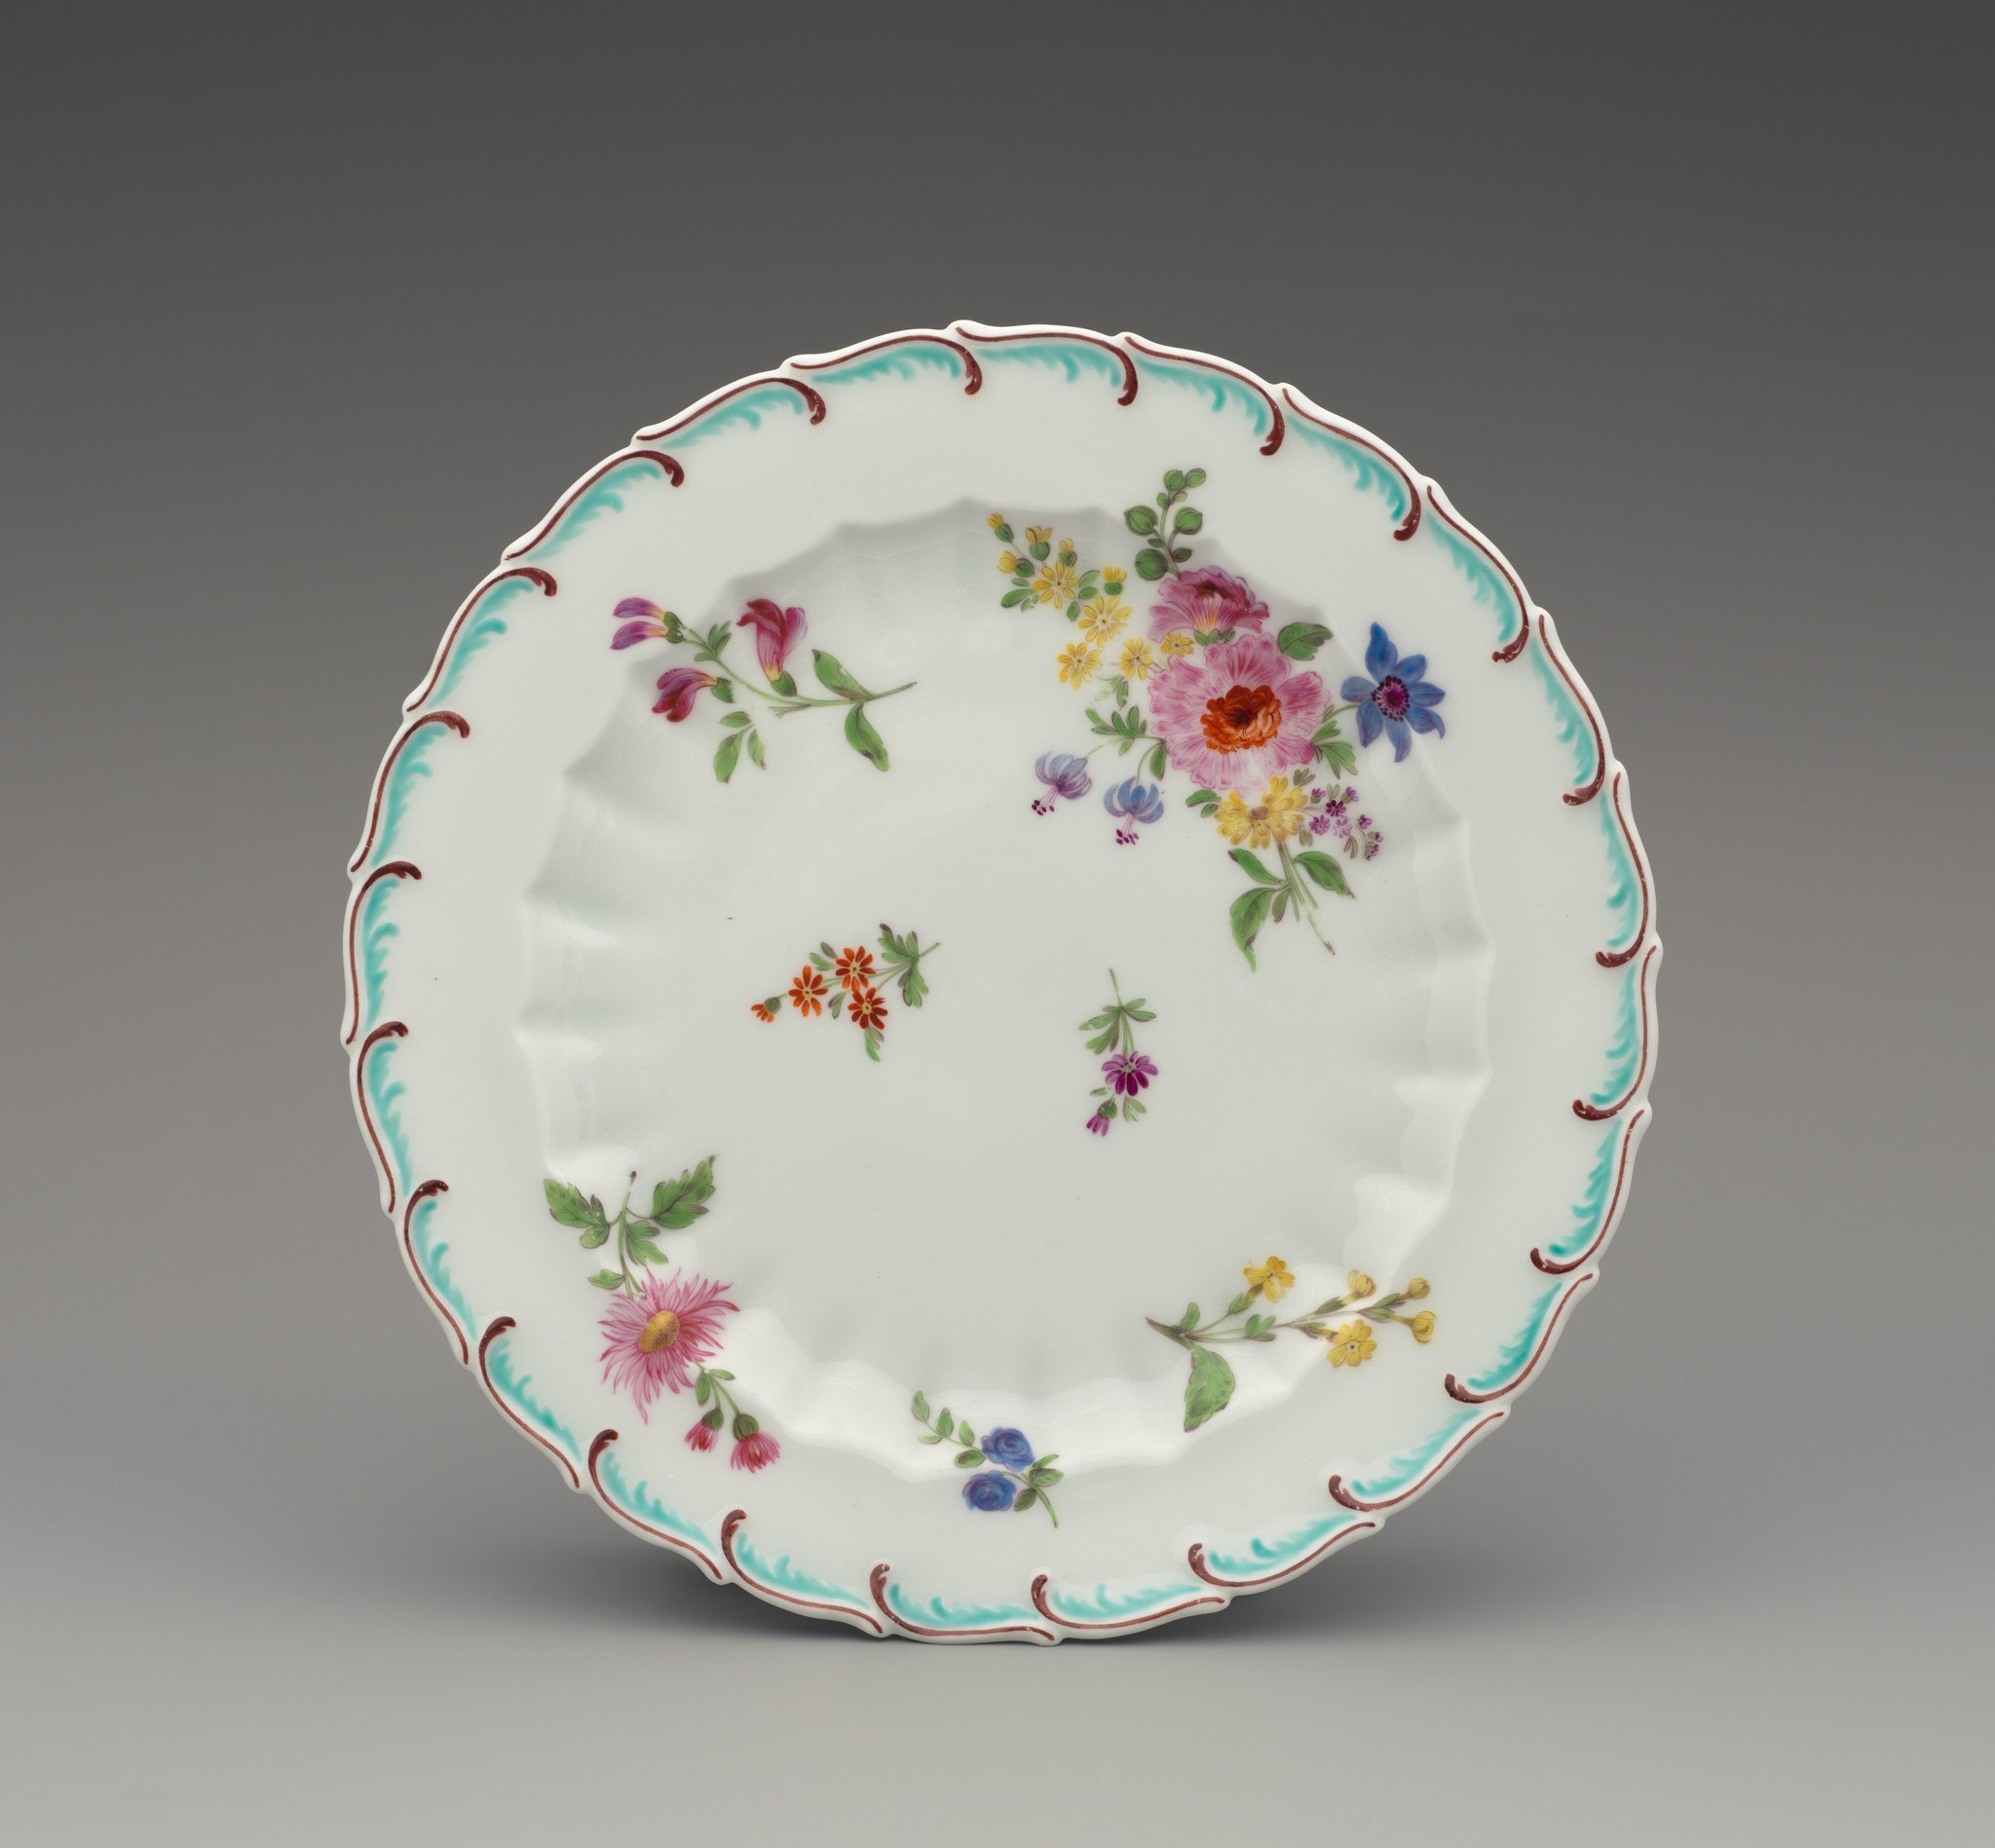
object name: plate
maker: edmé samson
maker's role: maker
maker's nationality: french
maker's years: 1810-1891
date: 1801-1900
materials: soft paste porcelain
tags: flowers